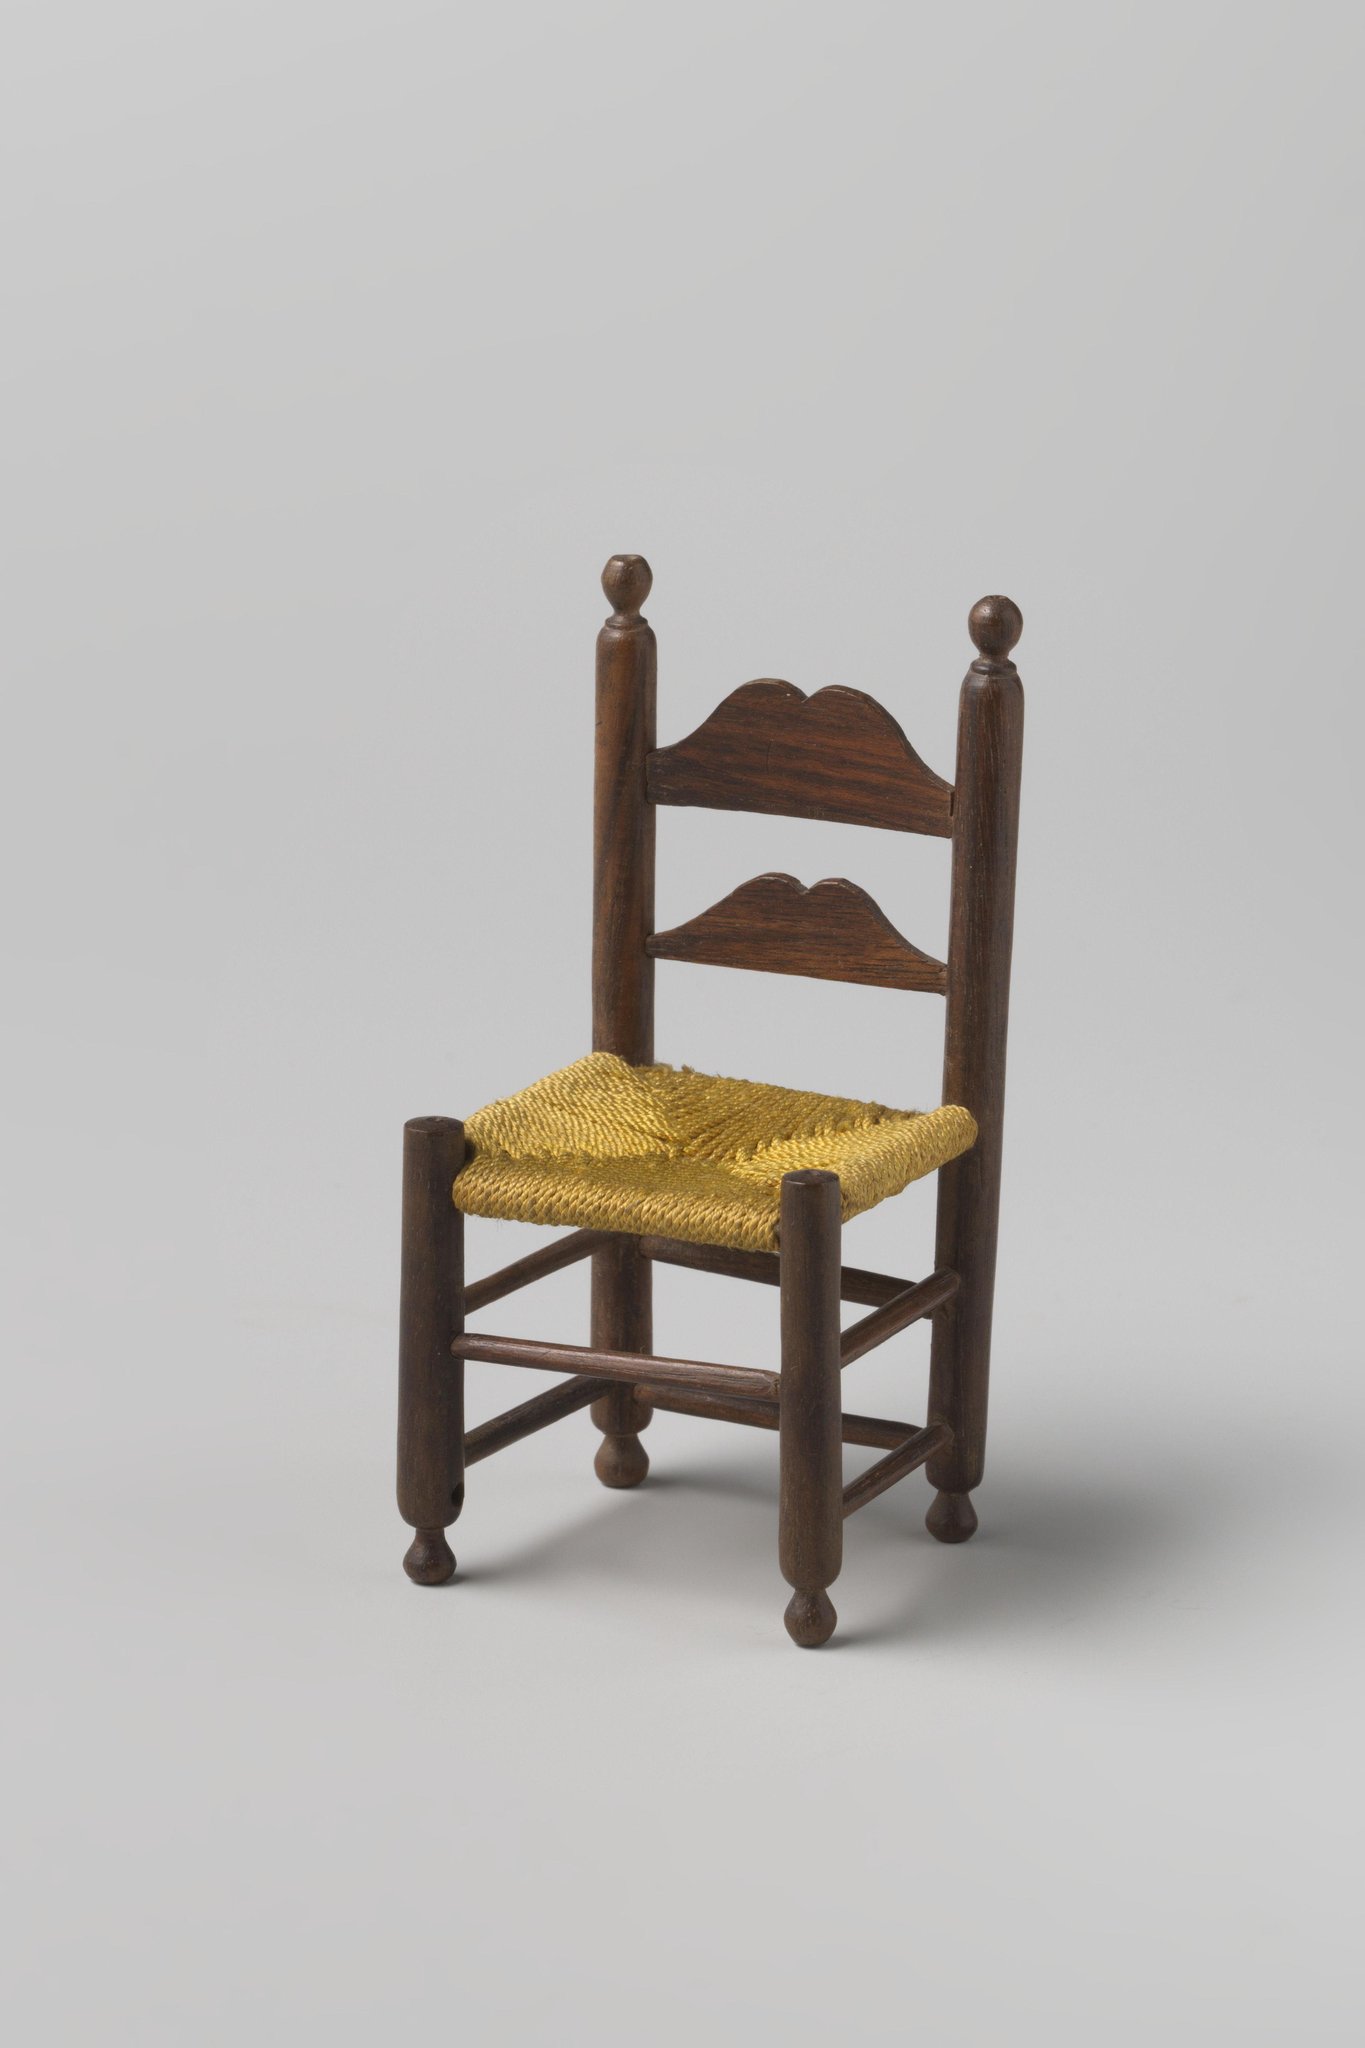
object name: miniature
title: Stoel van notenhout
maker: Anonymous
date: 1676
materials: silk, wood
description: Stoel van notenhout met gladde gedraaide stijlen en dwarsregels. De poten en rugstijlen eindigend in bollen. De rugleuning met twee platte dwarssporten in dubbele boog gezaagd. De zitting imitatie mattenbies, gevlochten van geel, getwist zijden koord.